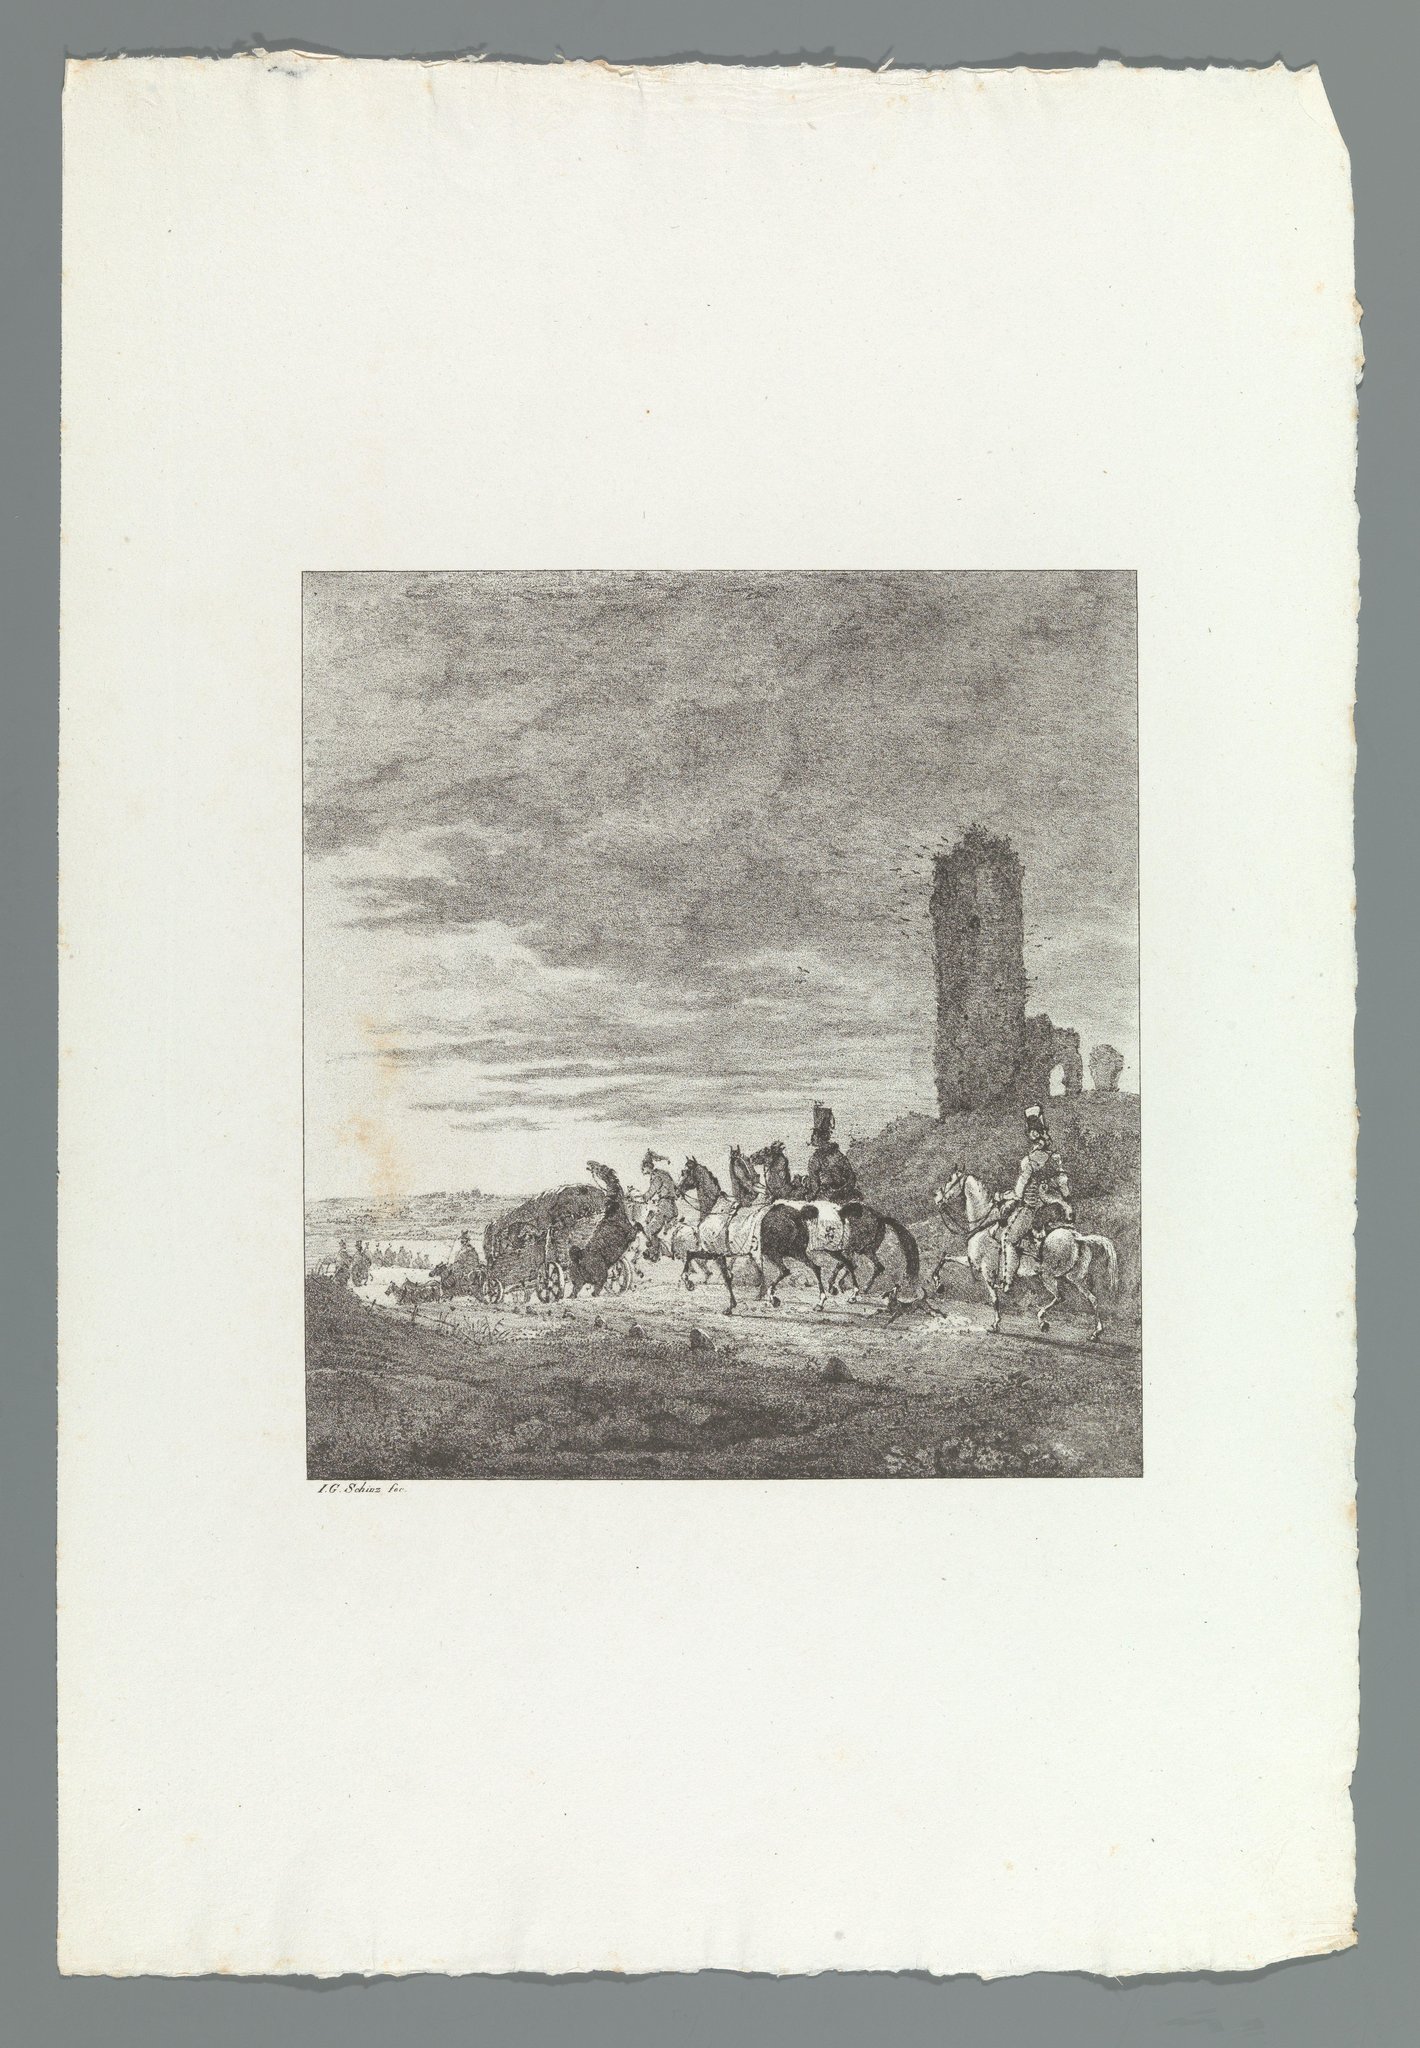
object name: print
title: Militairen te paard passeren de ruïne van een toren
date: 1822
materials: paper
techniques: lithograph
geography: zurich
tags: riding a horse, ass, or mule; rider, horseman, landscape with ruins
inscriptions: collector's mark: Lugt 2228, collector's mark: ‘RA WANKLER’, collector's mark: Lugt 2760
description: Krijtlitho afkomstig uit de 'Lithographische Original-Zeichnungen von J.G. Schinz, Zürich 1822'.